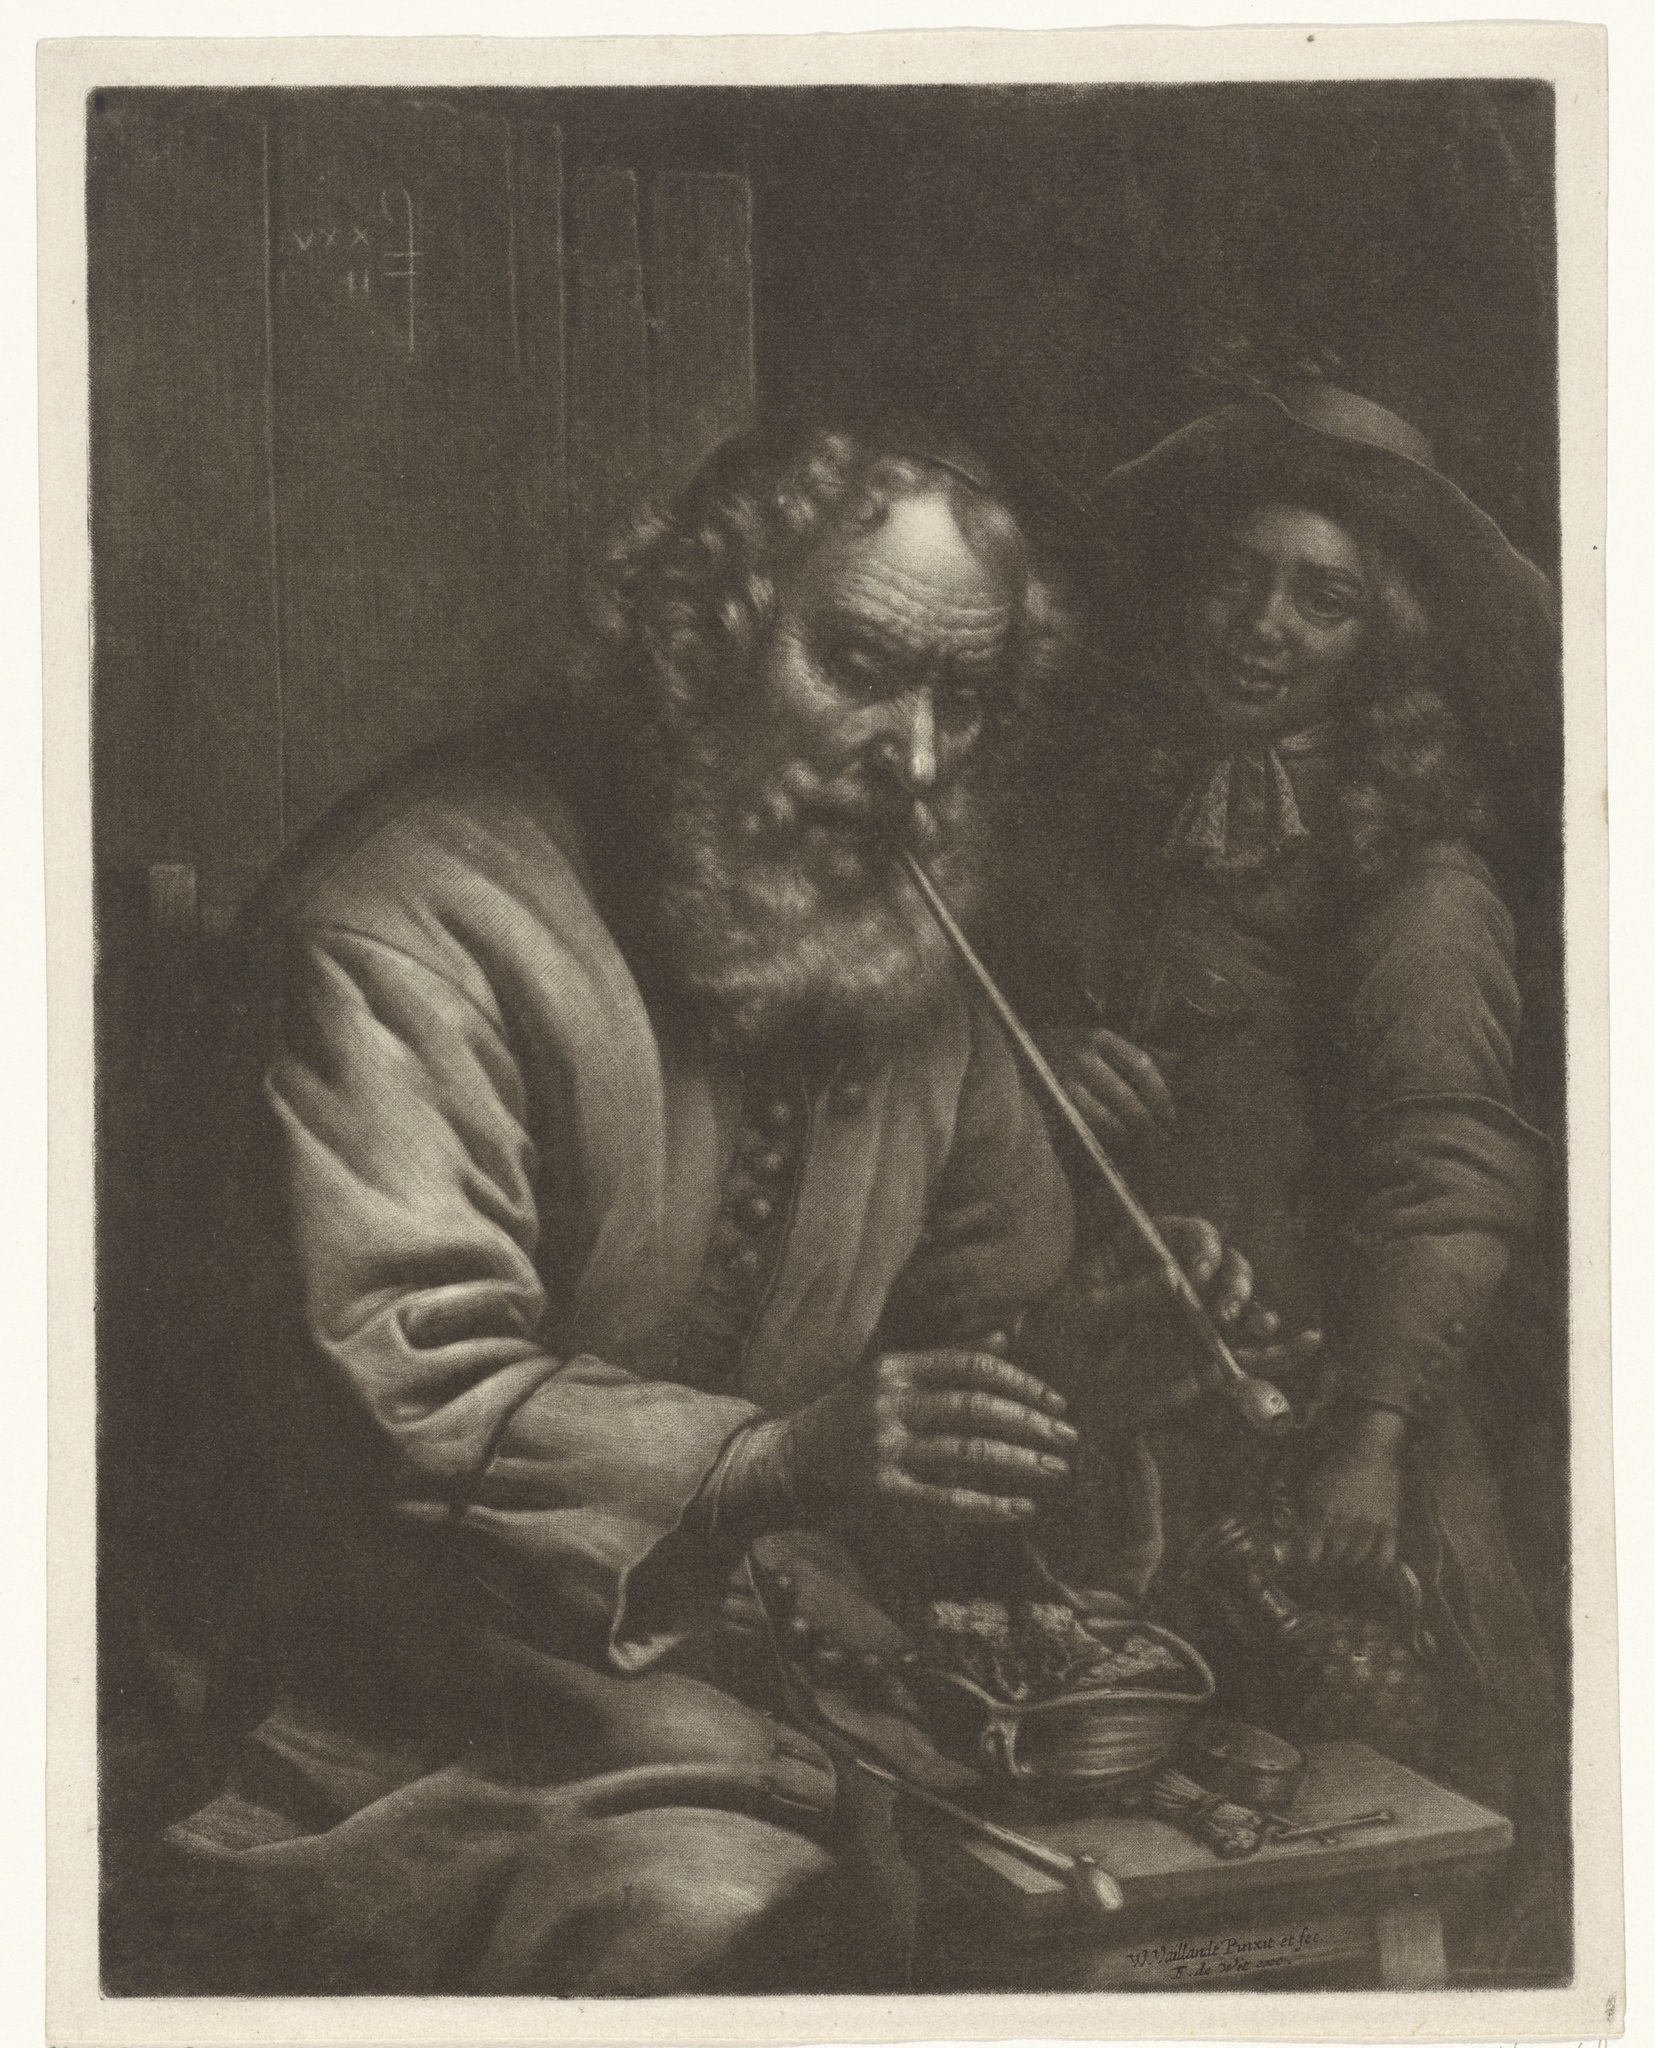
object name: print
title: Rokende oude man warmt zijn handen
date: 1658-1706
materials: paper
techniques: mezzotint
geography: amsterdam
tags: warming oneself at a fire (or hearth, stove, fire-pan, brazier), pipe ~ tobacco, old man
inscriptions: collector's mark: Lugt 2228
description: Een pijprokende oude man warmt zijn handen aan een potje. Schuin achter hem staat een glimlachende jongen met een kan en een glas in zijn hand.